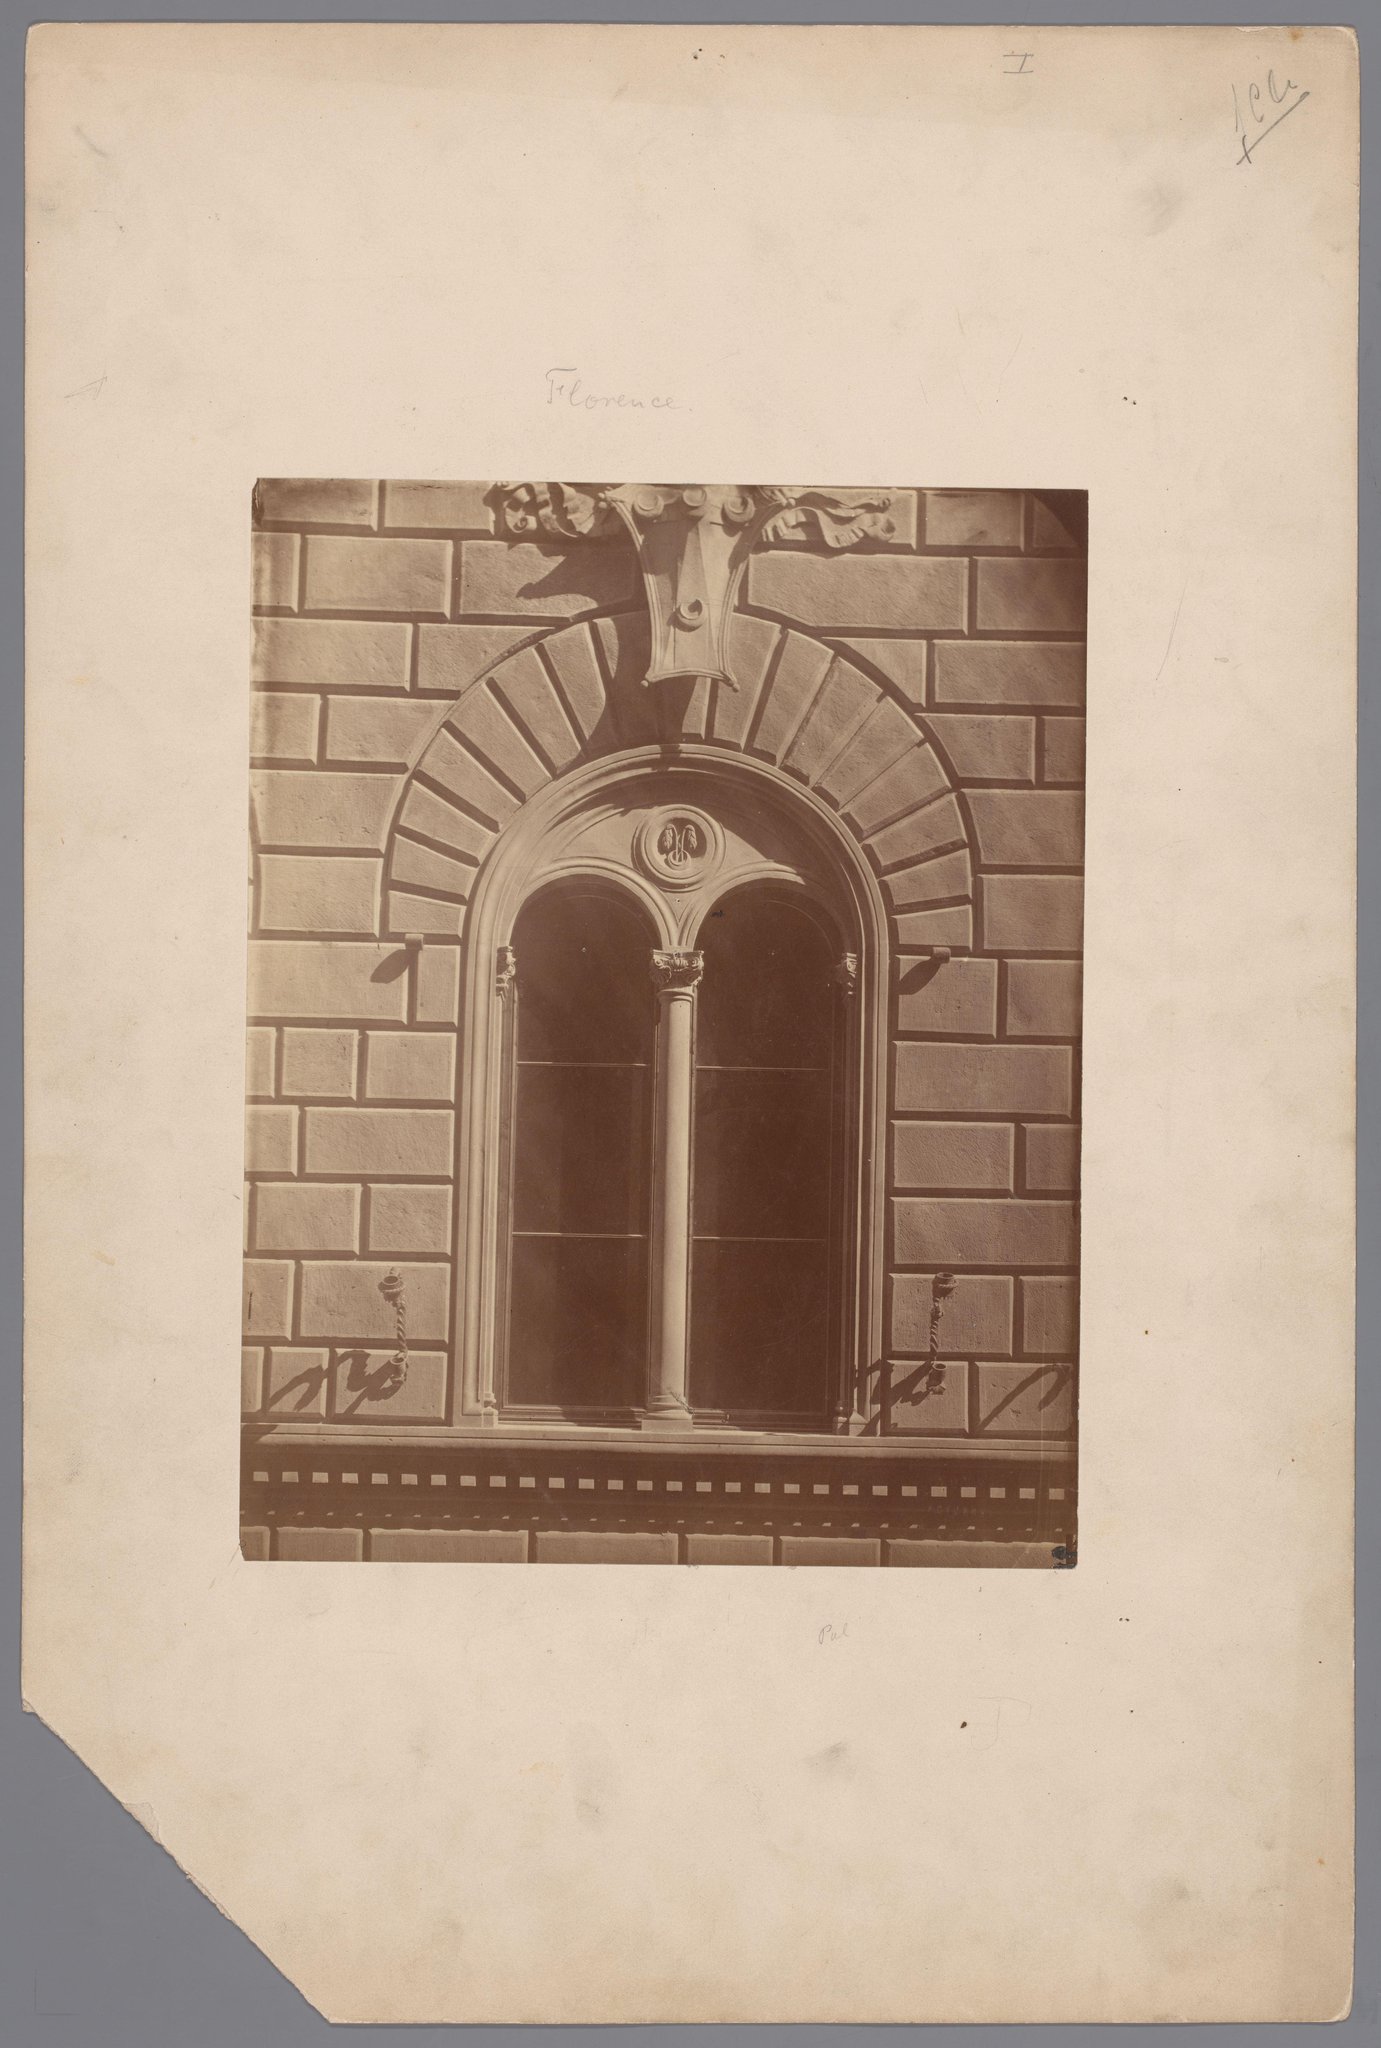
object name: photograph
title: Venster van een gebouw, mogelijk te Florence, Italië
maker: paolo lombardi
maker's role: fotograaf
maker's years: 1827-1890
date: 1851-1900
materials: cardboard, paper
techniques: albumen print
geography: florence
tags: window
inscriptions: inscription: ‘pul’, number: ‘I’, inscription: ‘fl 10 [...]’, collector's mark: ‘RIJKS SCHOOL VOOR KUNSTNIJVERHEID/ GROEP’, inscription: ‘i c k [?]’